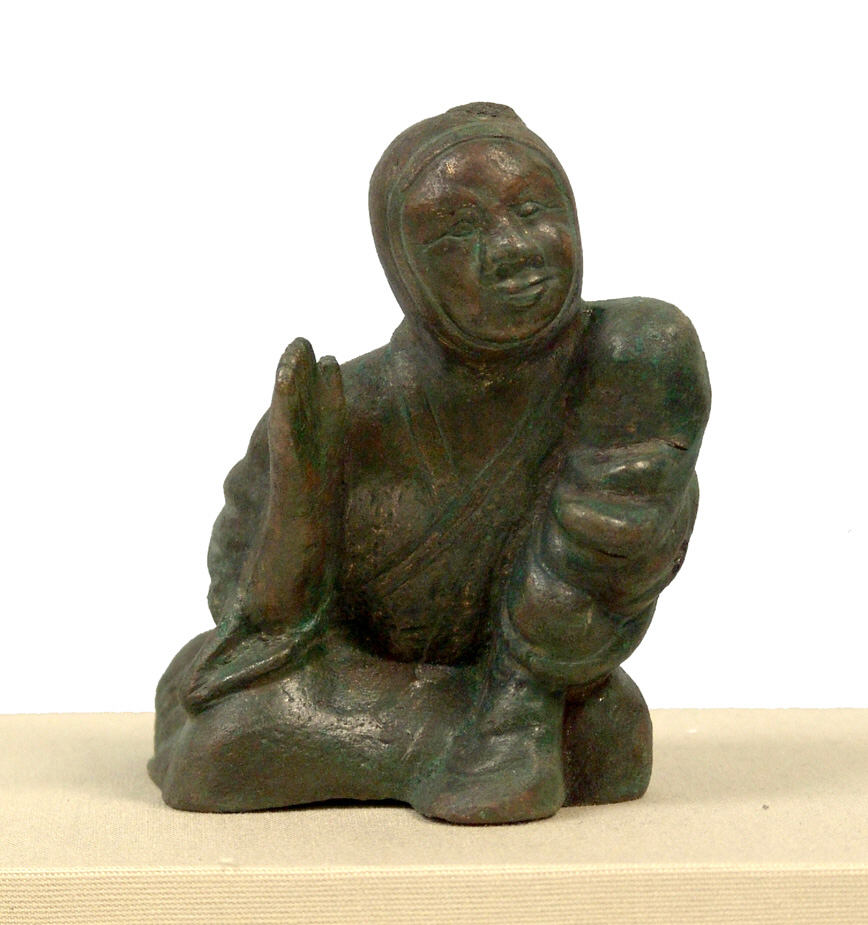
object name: weight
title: Weight in the Shape of Liubo Game Player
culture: chinese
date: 206 BCE-220 CE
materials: bronze, lead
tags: human figures,games